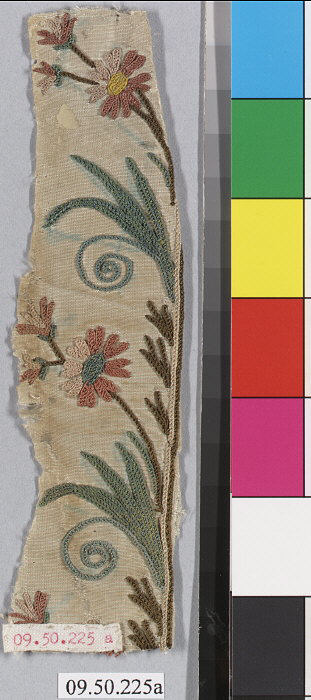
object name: fragment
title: Two fragments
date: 1701-1800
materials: silk